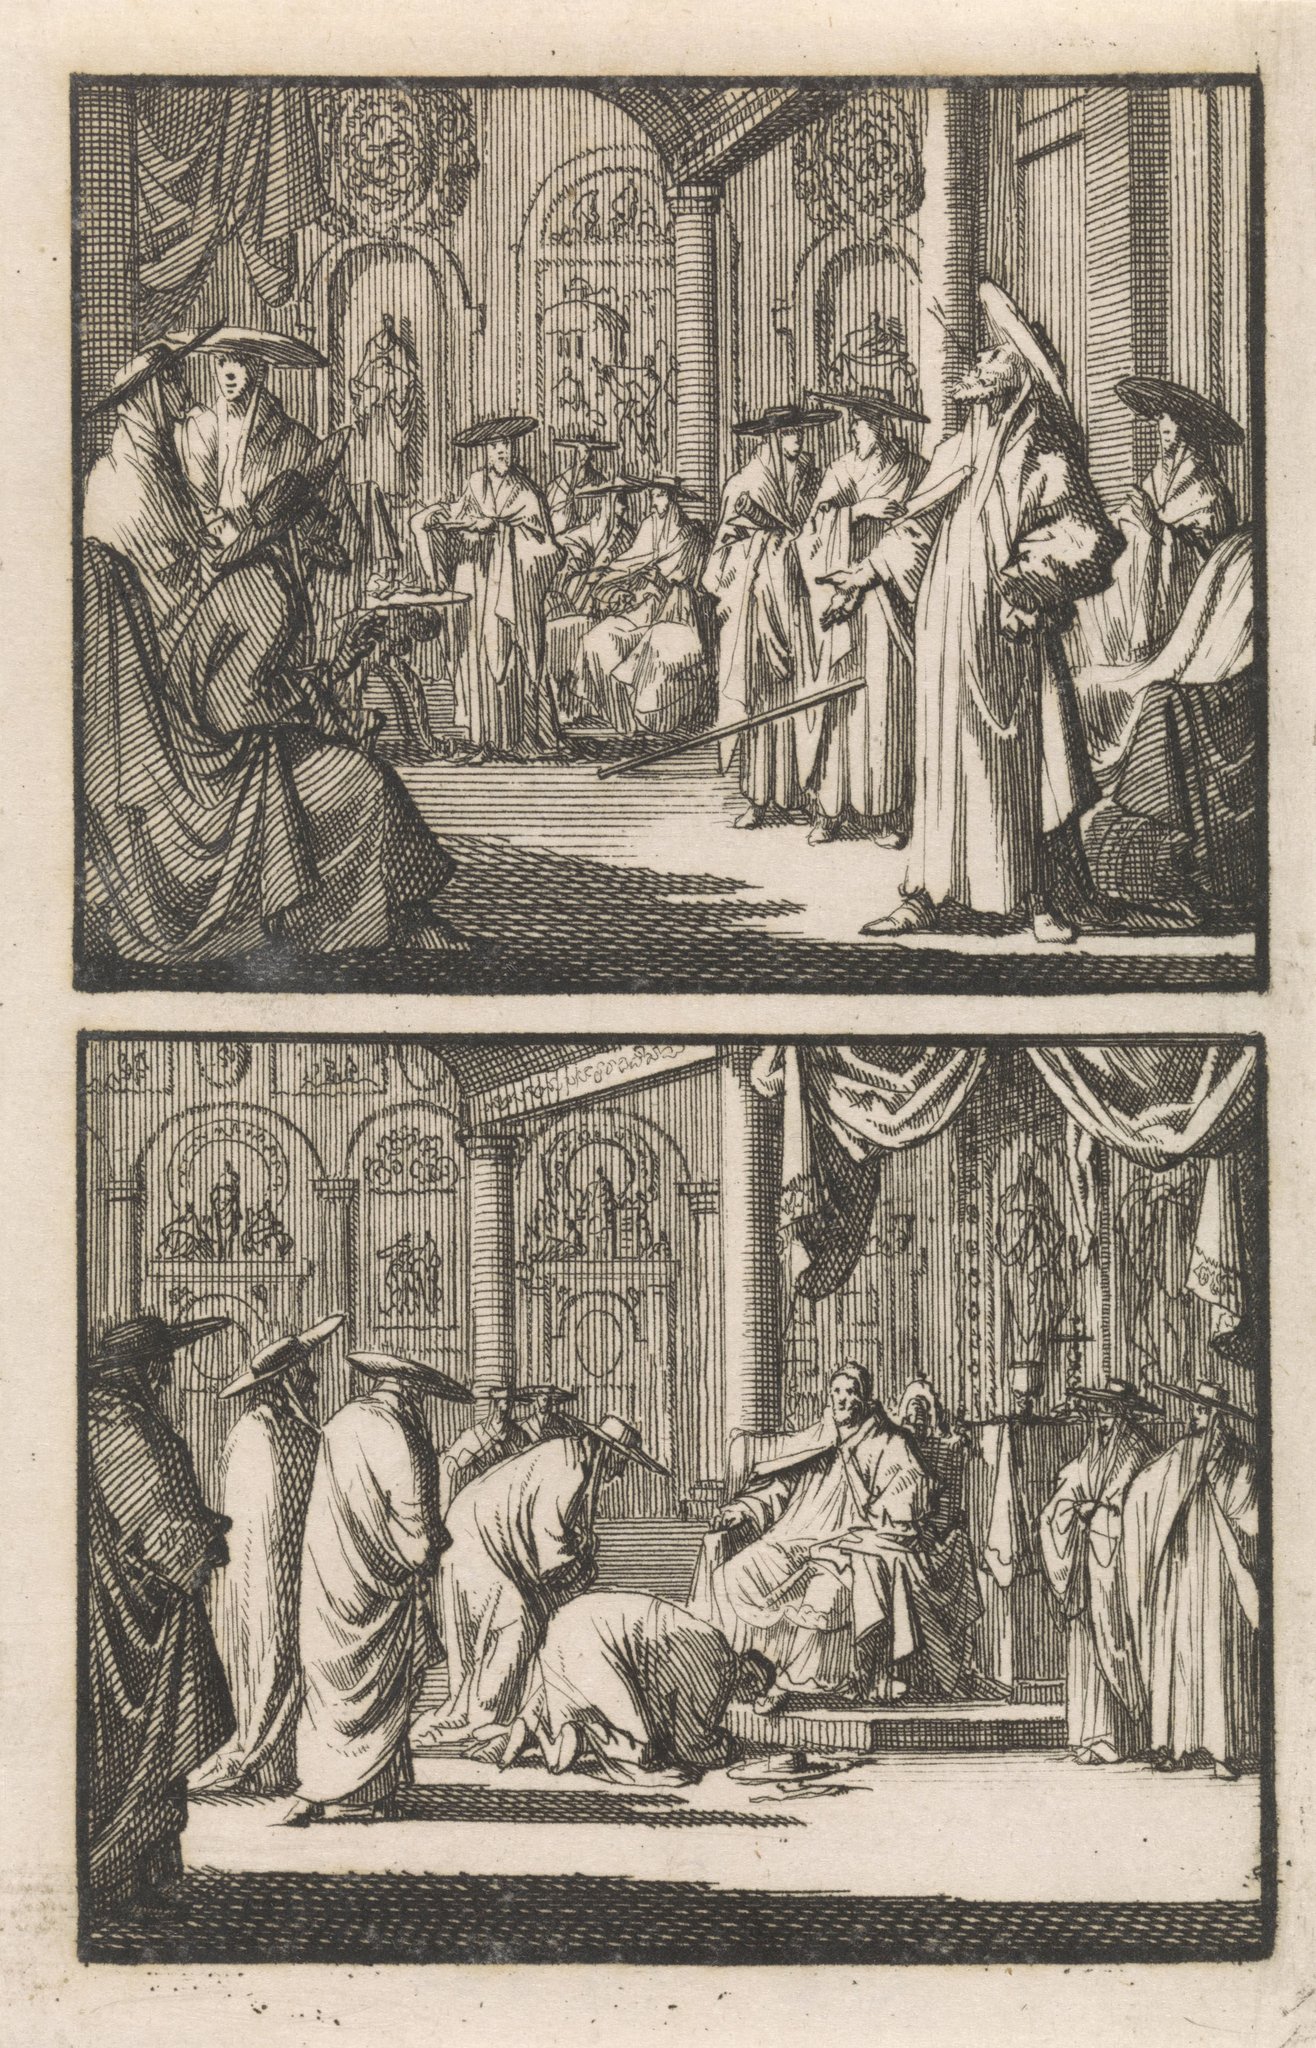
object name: print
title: Kardinaal Montalto richt zich na tot paus gekozen te zijn op en werpt zijn stokje weg / Kardinalen kussen de voet van paus Sixtus V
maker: jan luyken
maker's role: draughtsman, print maker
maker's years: 1649-1712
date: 1697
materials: paper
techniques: etching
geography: amsterdam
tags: rome, sixtus v, installation of a pope, kissing the pope's feet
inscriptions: collector's mark: Lugt 2228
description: Proefdruk van illustratie uit: Leti, Gregorio. Het leeven van Sixtus den Vyfden, paus van Rome, 2 delen. Gillis en Johannes Janssonius van Waesberge en wed. Steven Swart, 1697, dl. I.